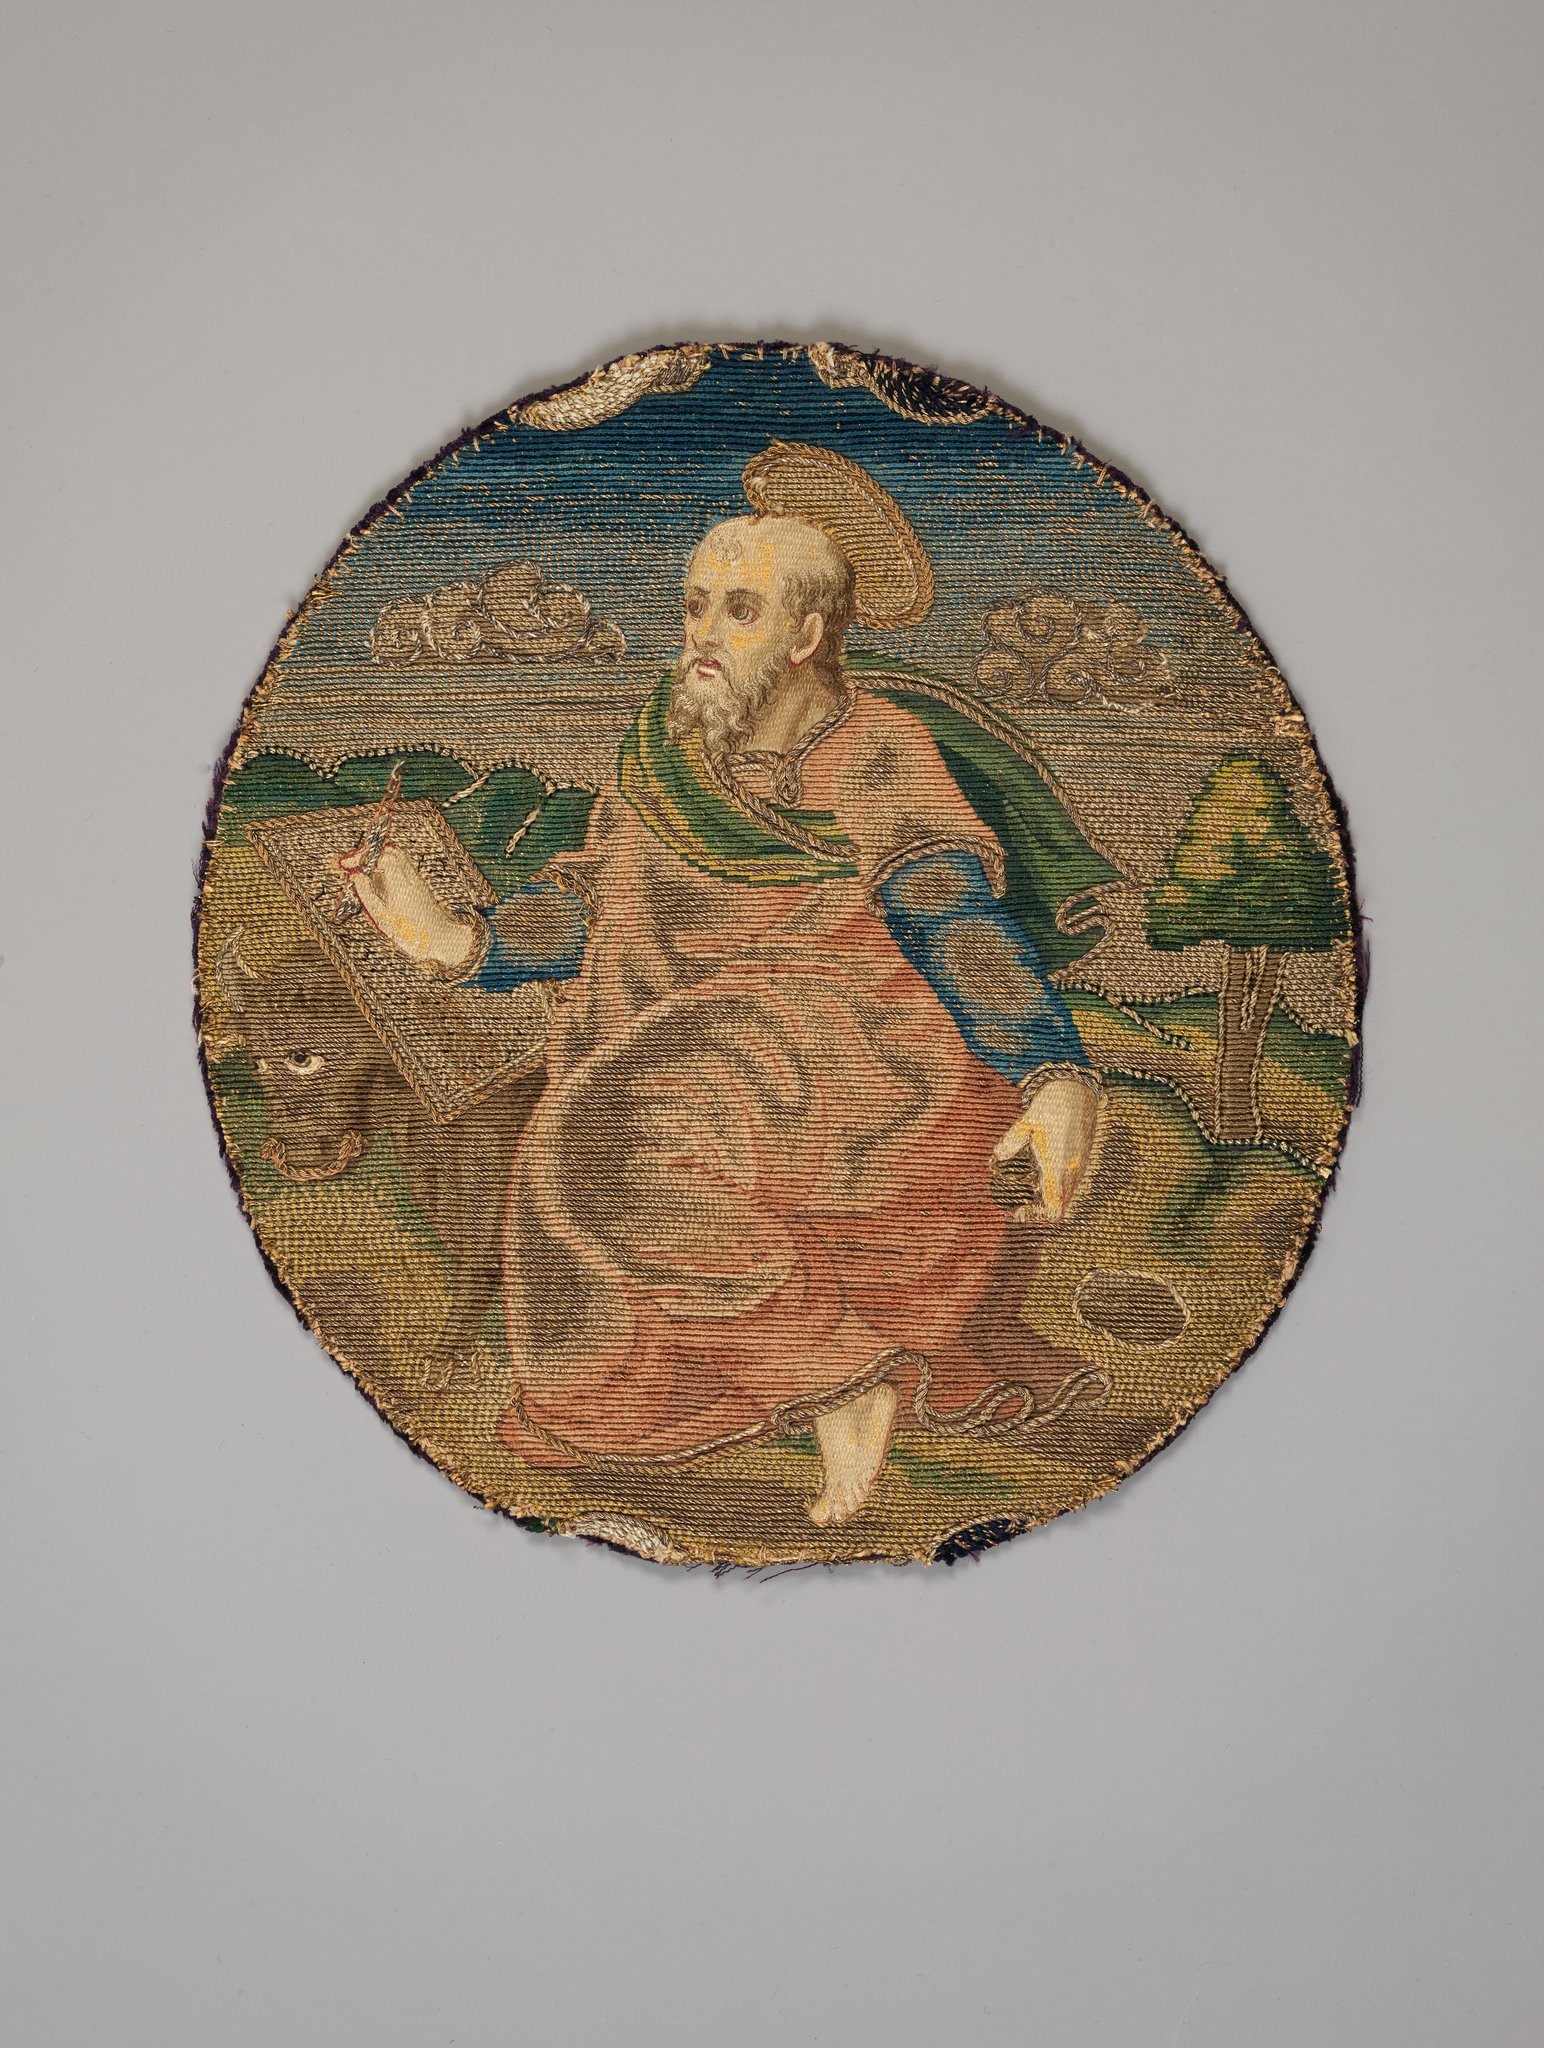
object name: panel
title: Saint Luke (one of four)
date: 1567-1633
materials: canvas, metal thread, silk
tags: animals,men,trees